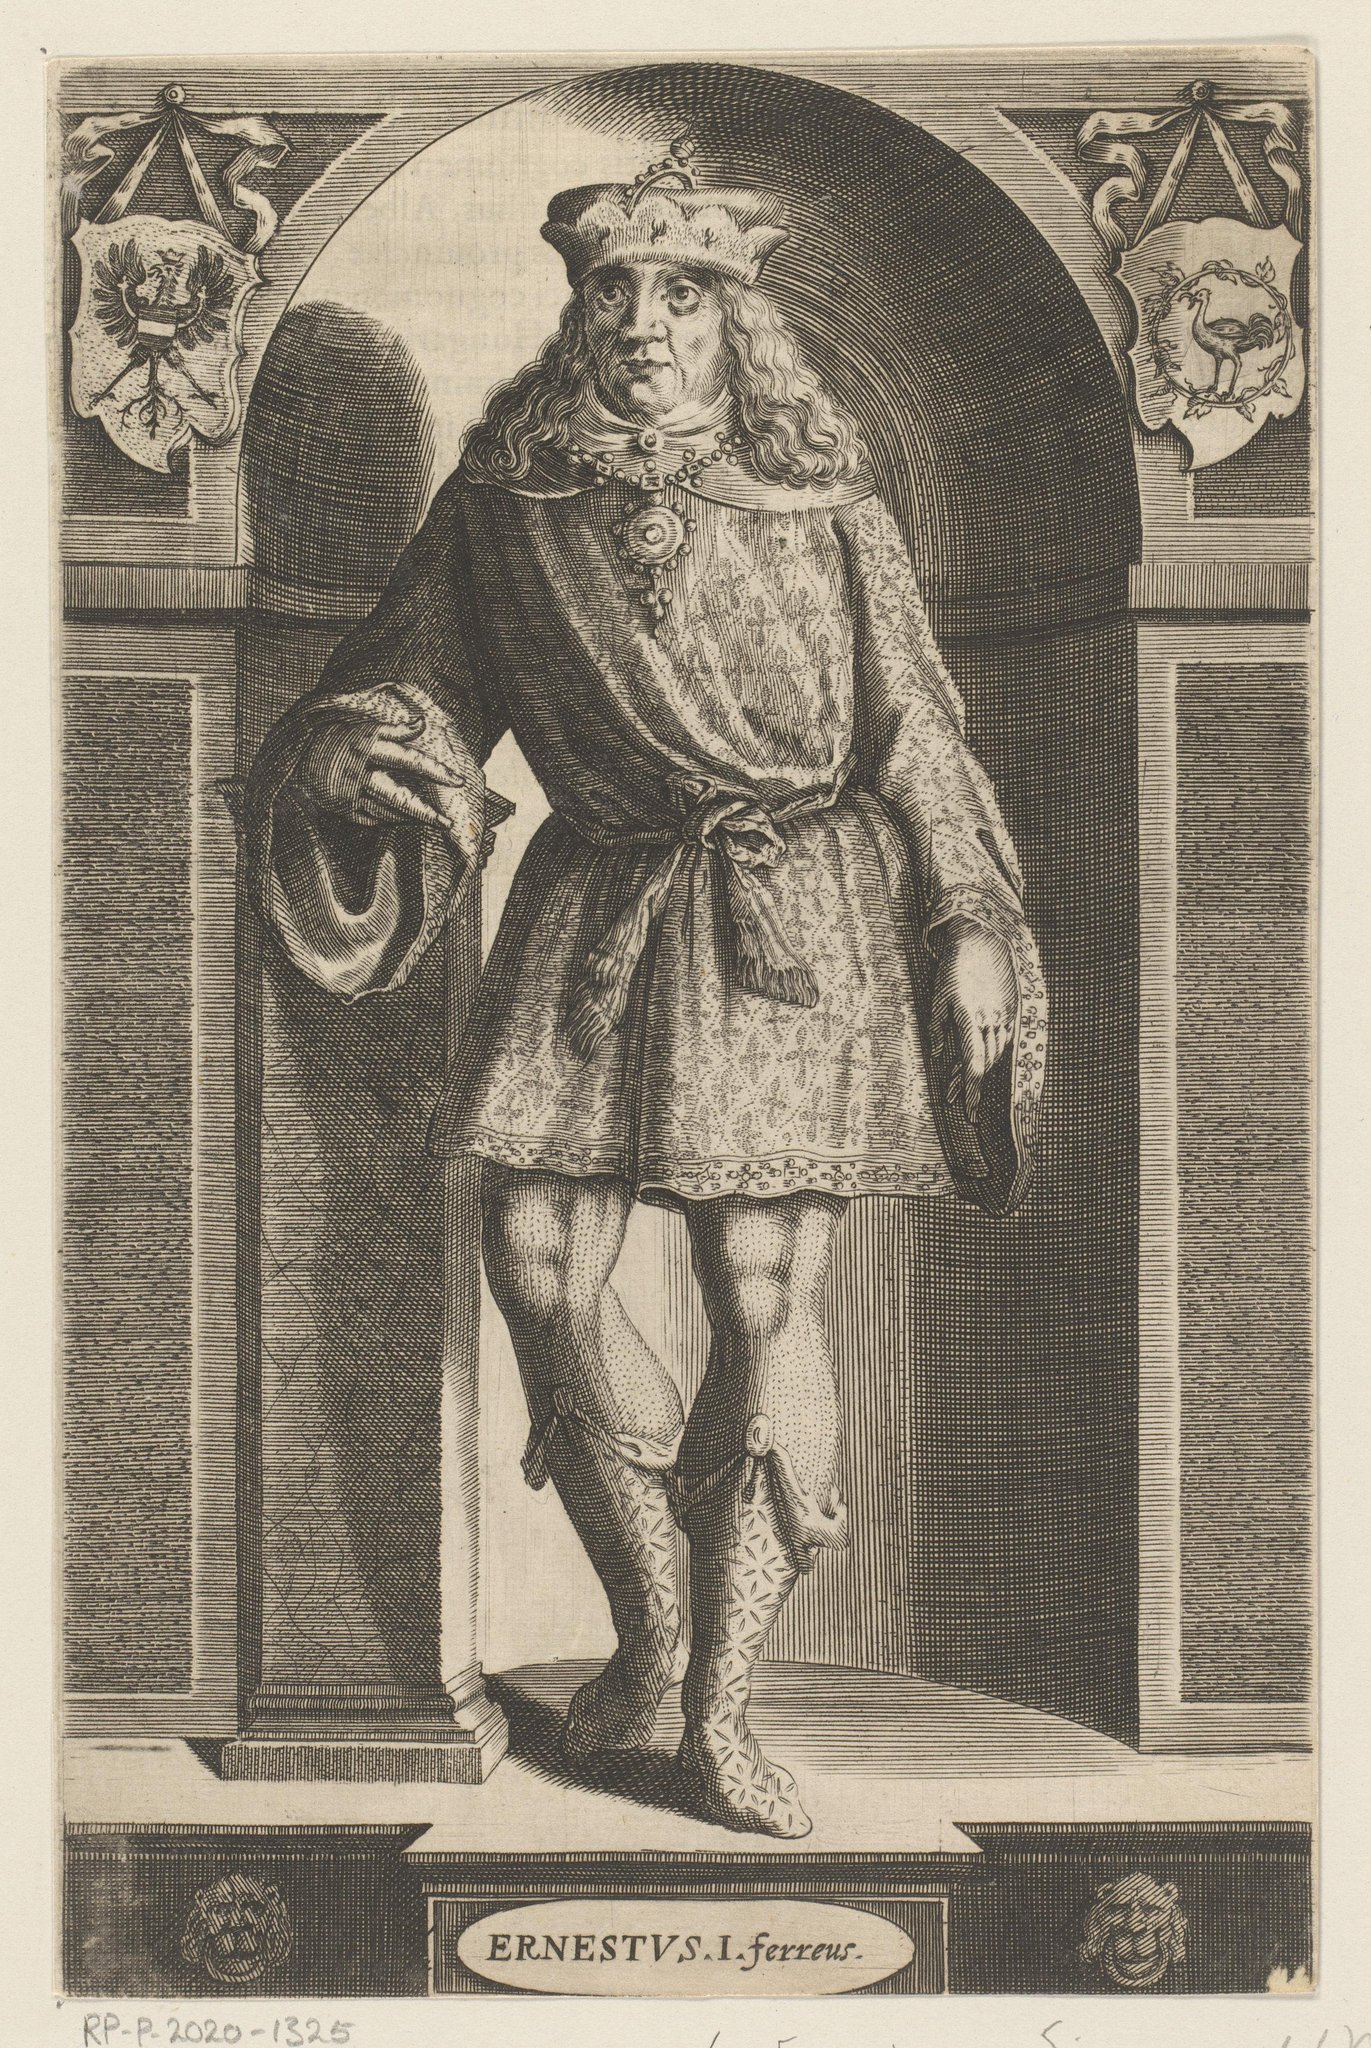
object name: print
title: Portret van Ernst I, aartshertog van Oostenrijk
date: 1599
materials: paper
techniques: engraving, letterpress printing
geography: augsburg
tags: historical persons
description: Prent uit: Henning, Marcus. Tirolensium Principum Comitum. Augsburg: Johannes Praetorius, 1599.